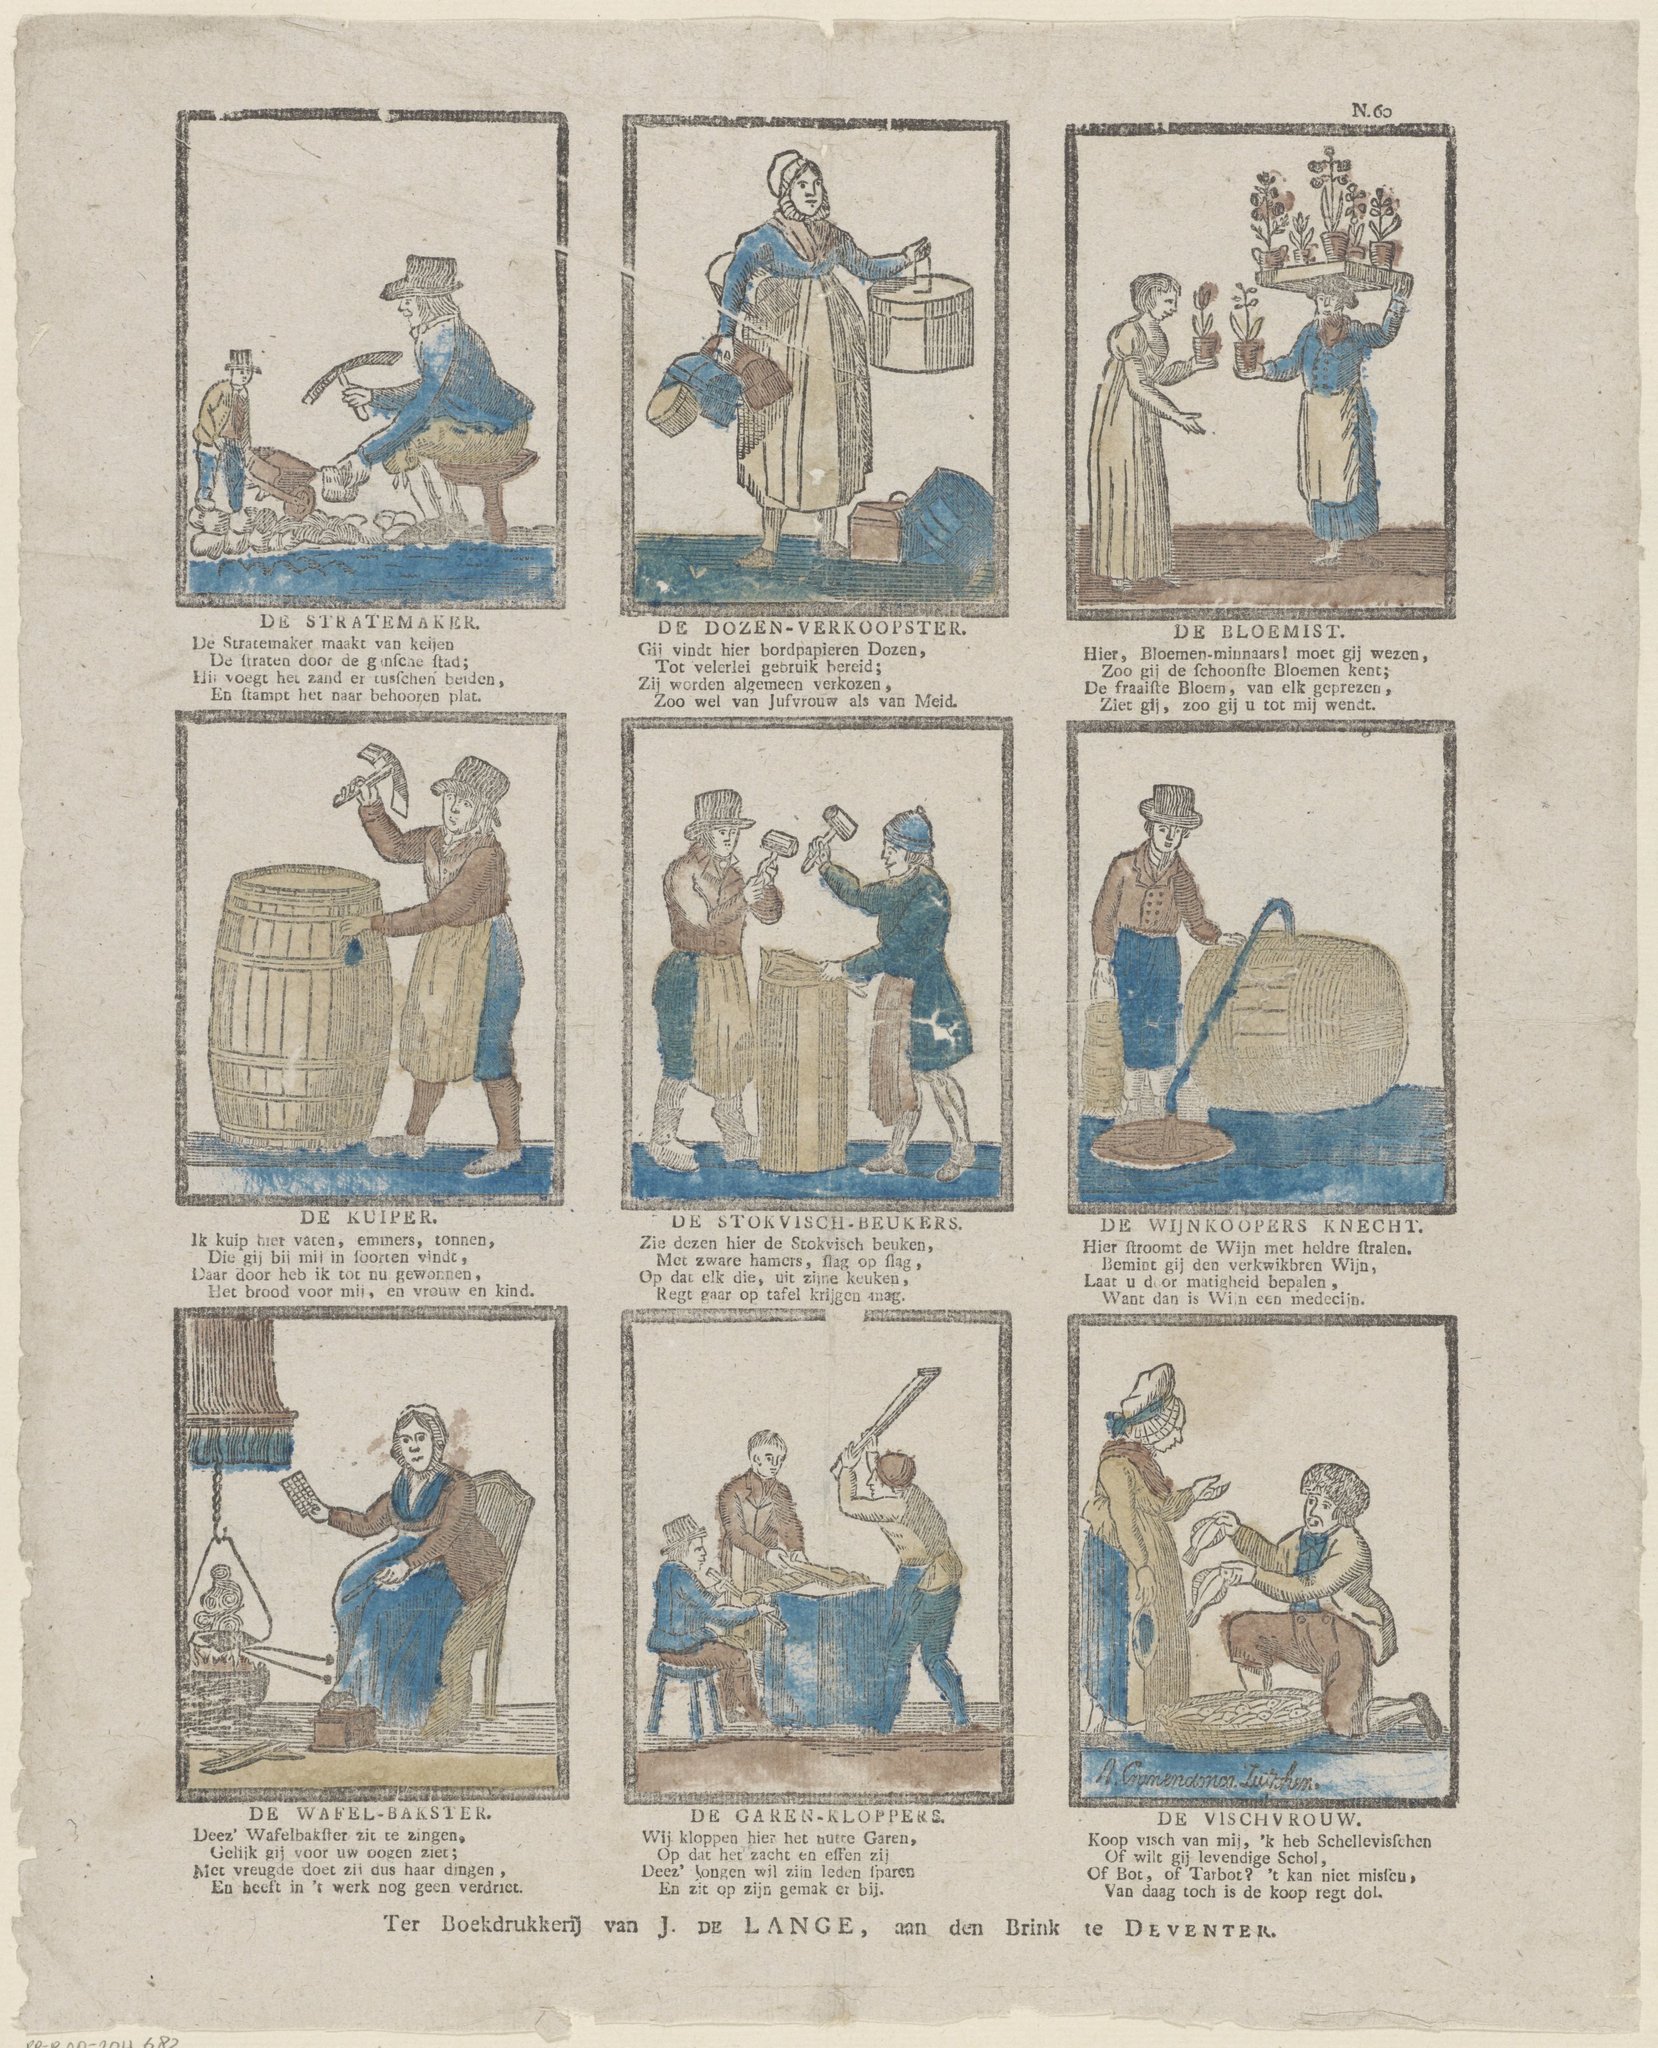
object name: print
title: Ambachten en beroepen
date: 1822-1849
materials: paper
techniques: colour, letterpress printing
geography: zutphen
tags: craft-production, skilled handiwork, working class, labourers, street-trader, crafts and industries, merchant, salesman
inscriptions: collector's mark: Lugt 2760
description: Blad met 9 voorstellingen van ambachtslieden en beroepen, zoals stratenmaker, dozenverkoopster en bloemist. Onder elke afbeelding een titel en een vierregelig vers. Genummerd rechtsboven: N. 60.